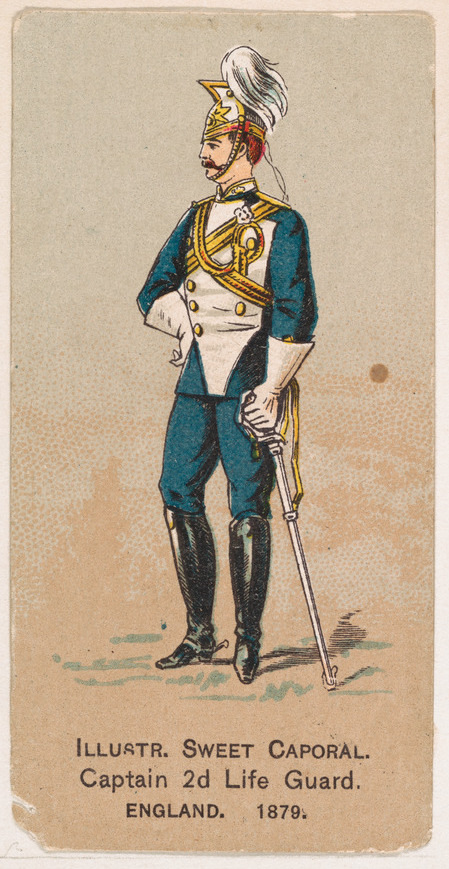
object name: print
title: Captain, 2nd Life Guard, England, 1879, from the Military Series (N224) issued by Kinney Tobacco Company to promote Sweet Caporal Cigarettes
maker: kinney brothers tobacco company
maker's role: publisher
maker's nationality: american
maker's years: 1869-2011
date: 1888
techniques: color lithograph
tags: military,men